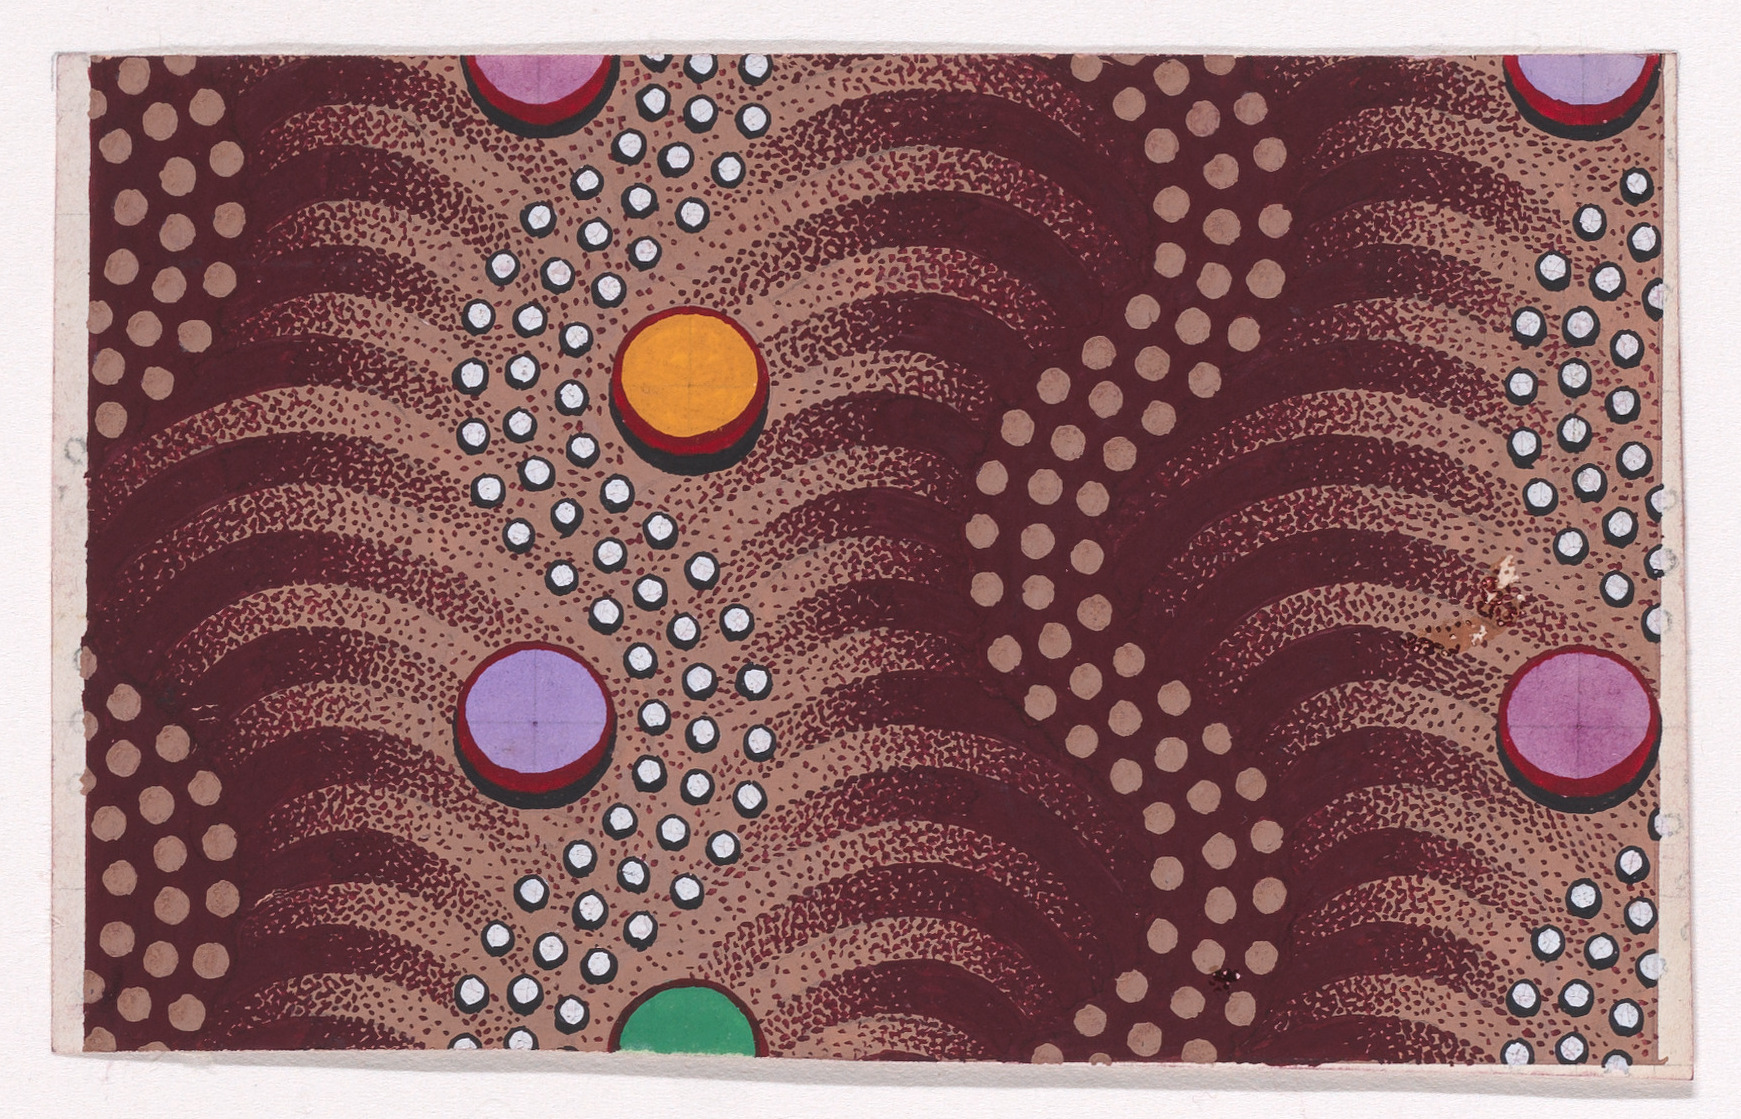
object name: drawing ornament architecture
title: Textile Design with Vertical Undulating Garlands of Pearls with Alternatig Larger Pearls Separated by Undulating Garlands of Dots with Offsetting Stylized Palm Leaves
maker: anonymous, alsatian, 19th century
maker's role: artist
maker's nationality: alsatian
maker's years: 1800-1900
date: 1840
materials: gouache